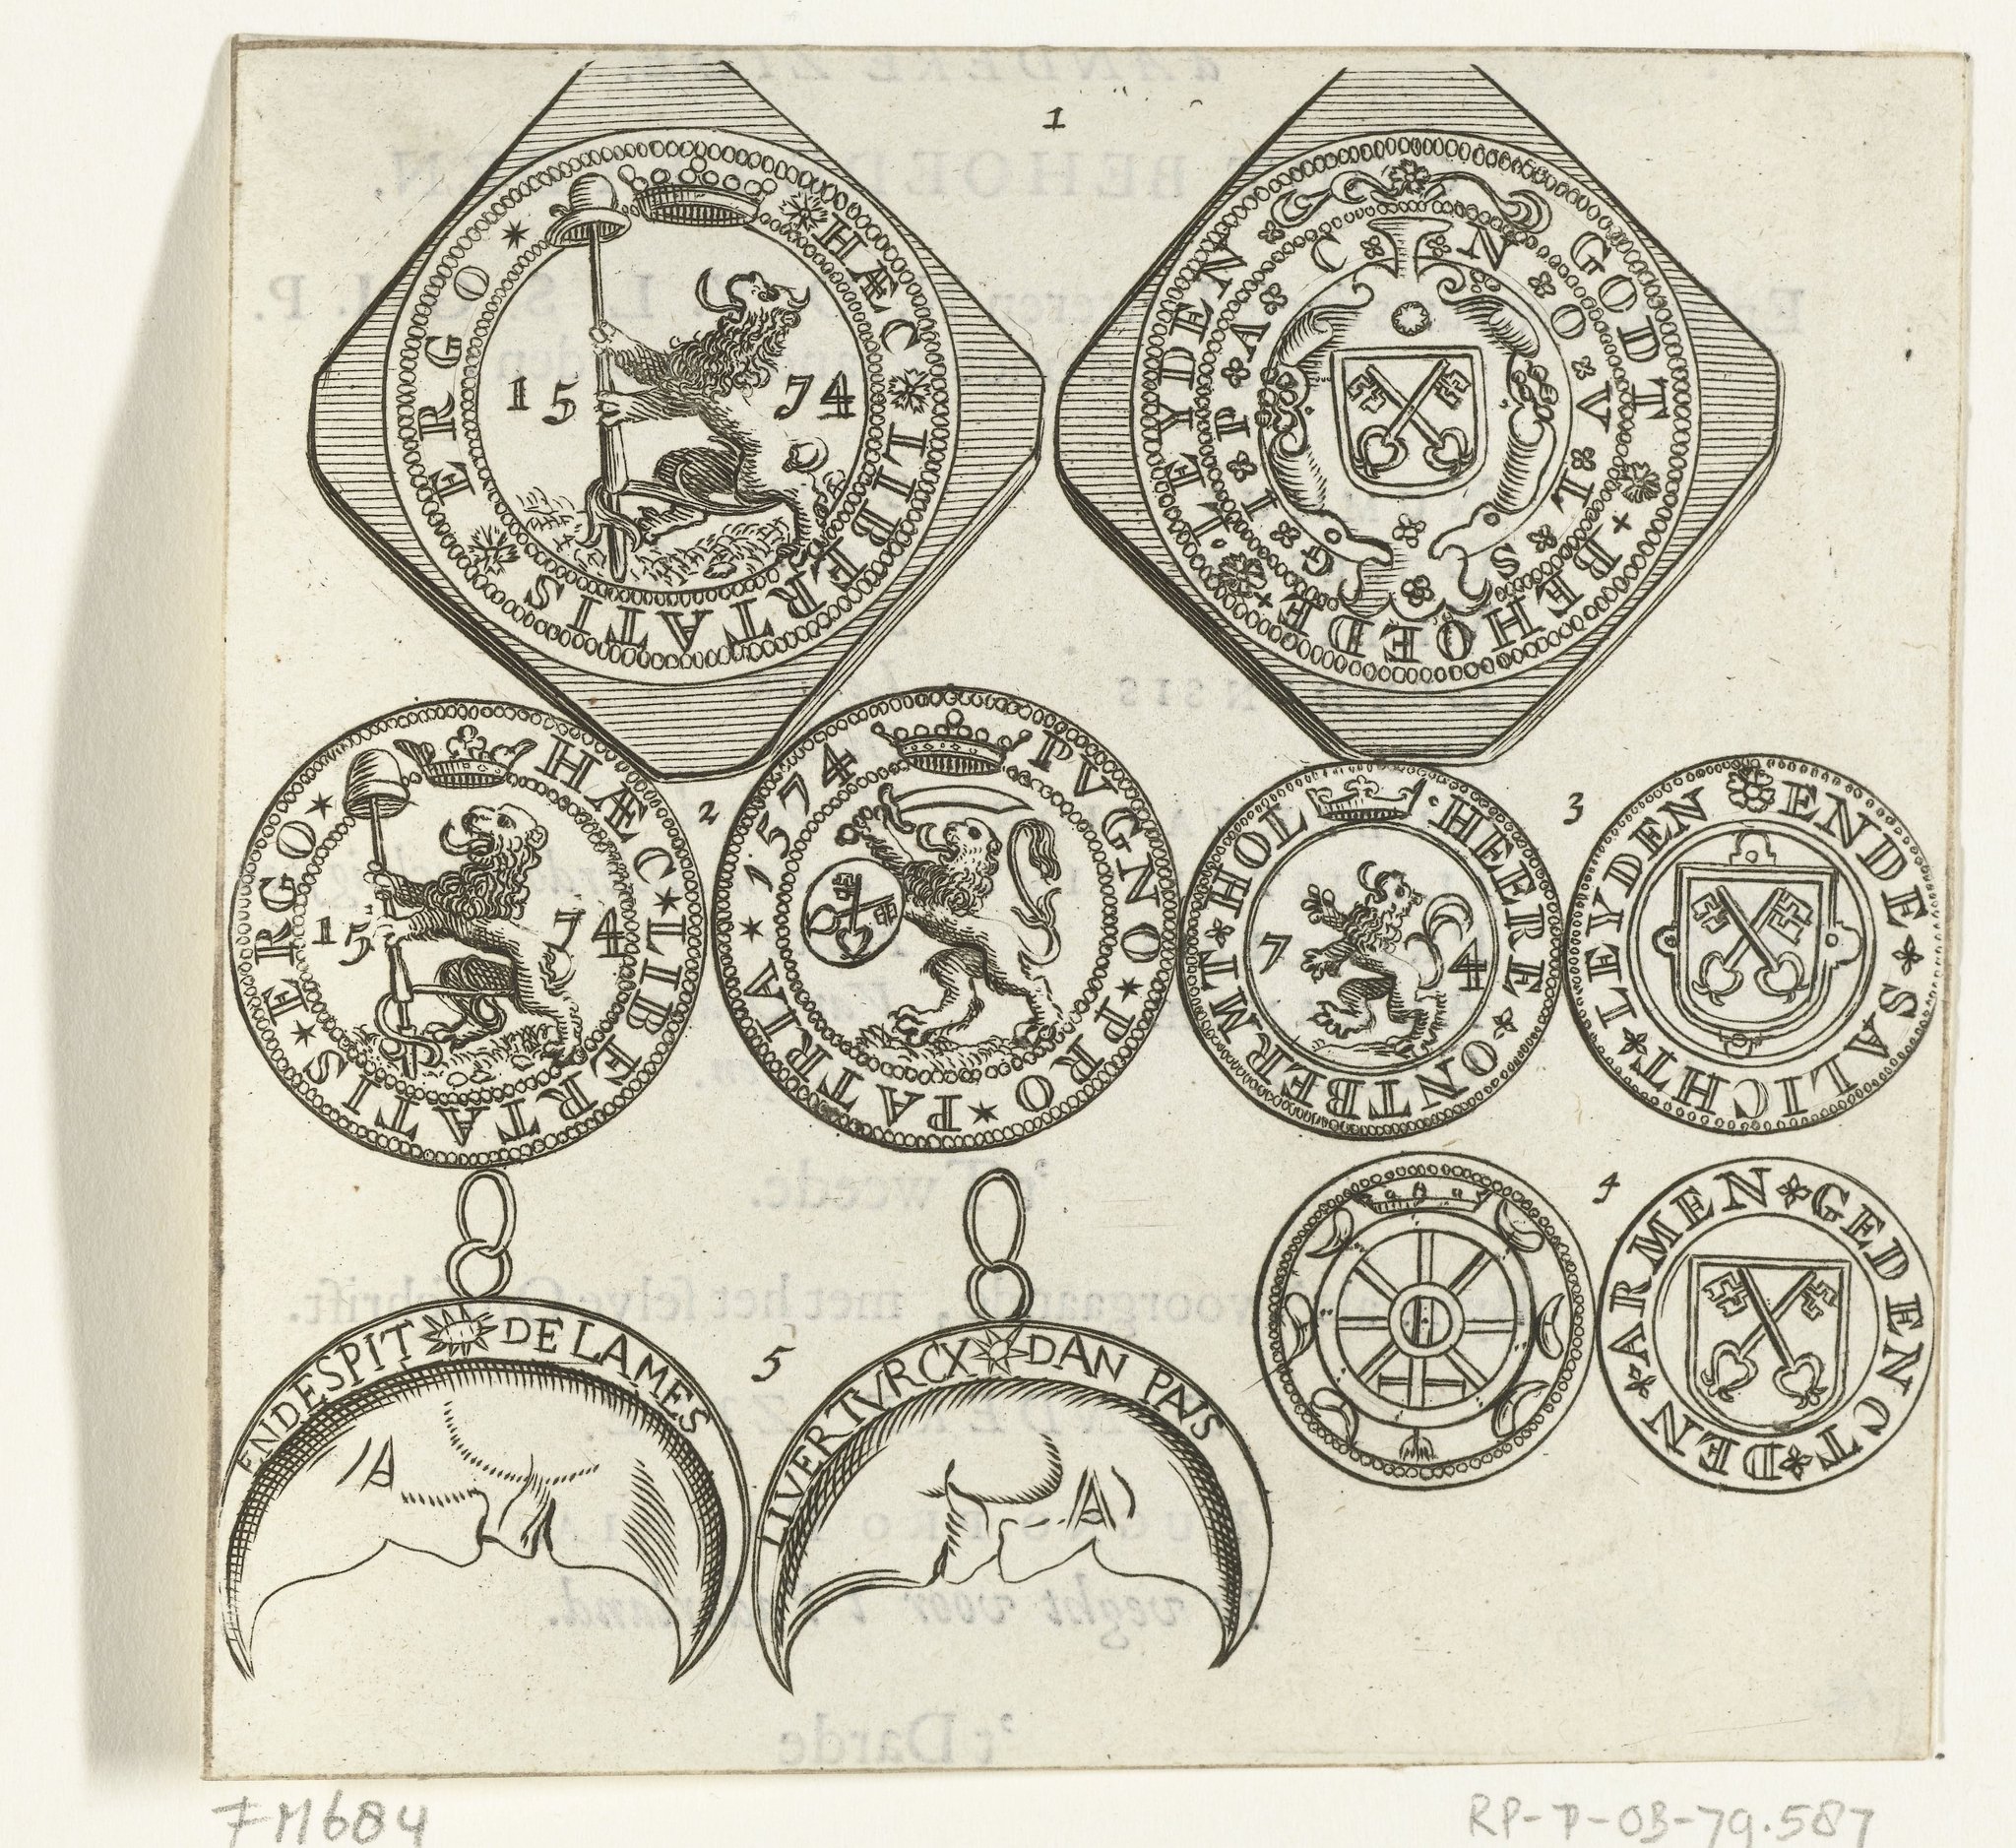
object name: historical object representation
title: Noodmunten en geuzenpenningen uit beleg van Leiden, 1574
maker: Anonymous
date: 1700-1799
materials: paper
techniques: engraving, etching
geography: netherlands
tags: medal (considered as a piece of sculpture, regardless of its specific function), leiden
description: Illustratie afkomstig uit een onbekend werk.